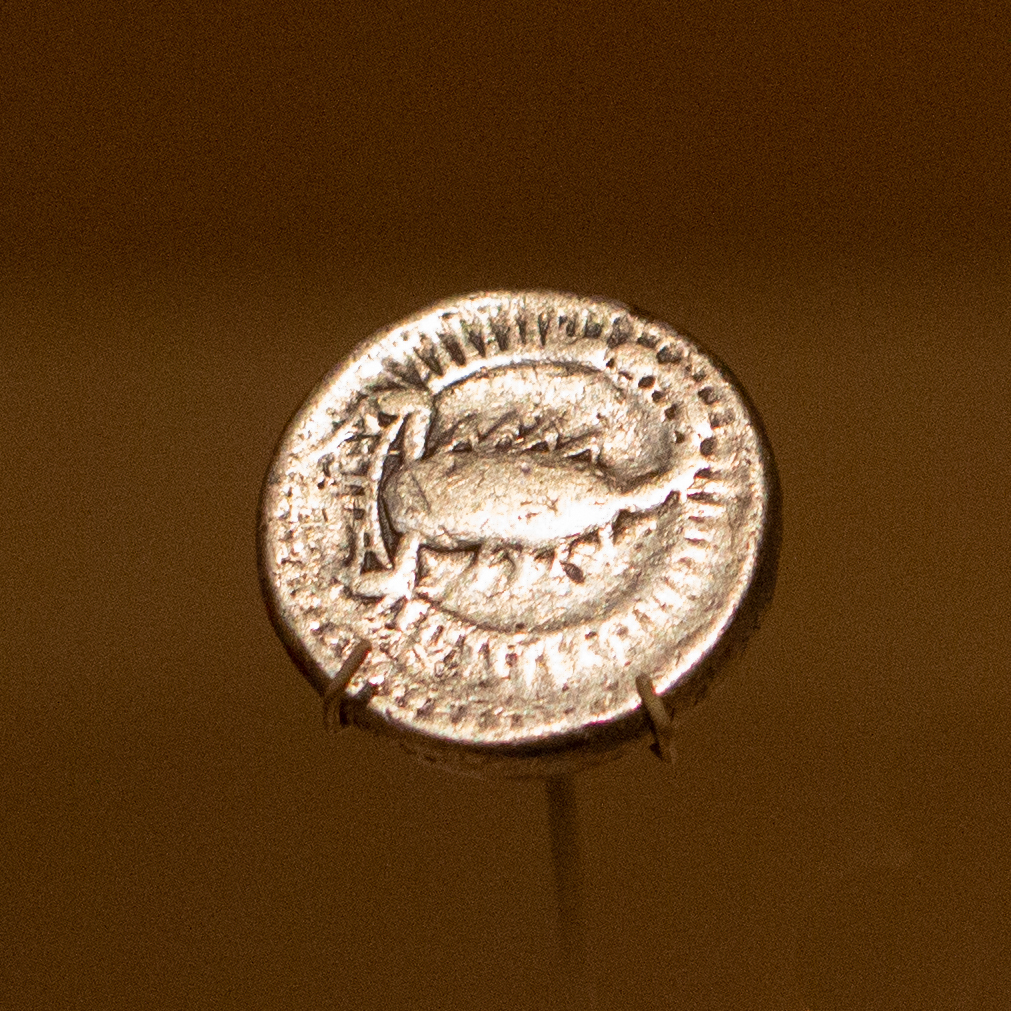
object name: coin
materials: silver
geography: india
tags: scorpions